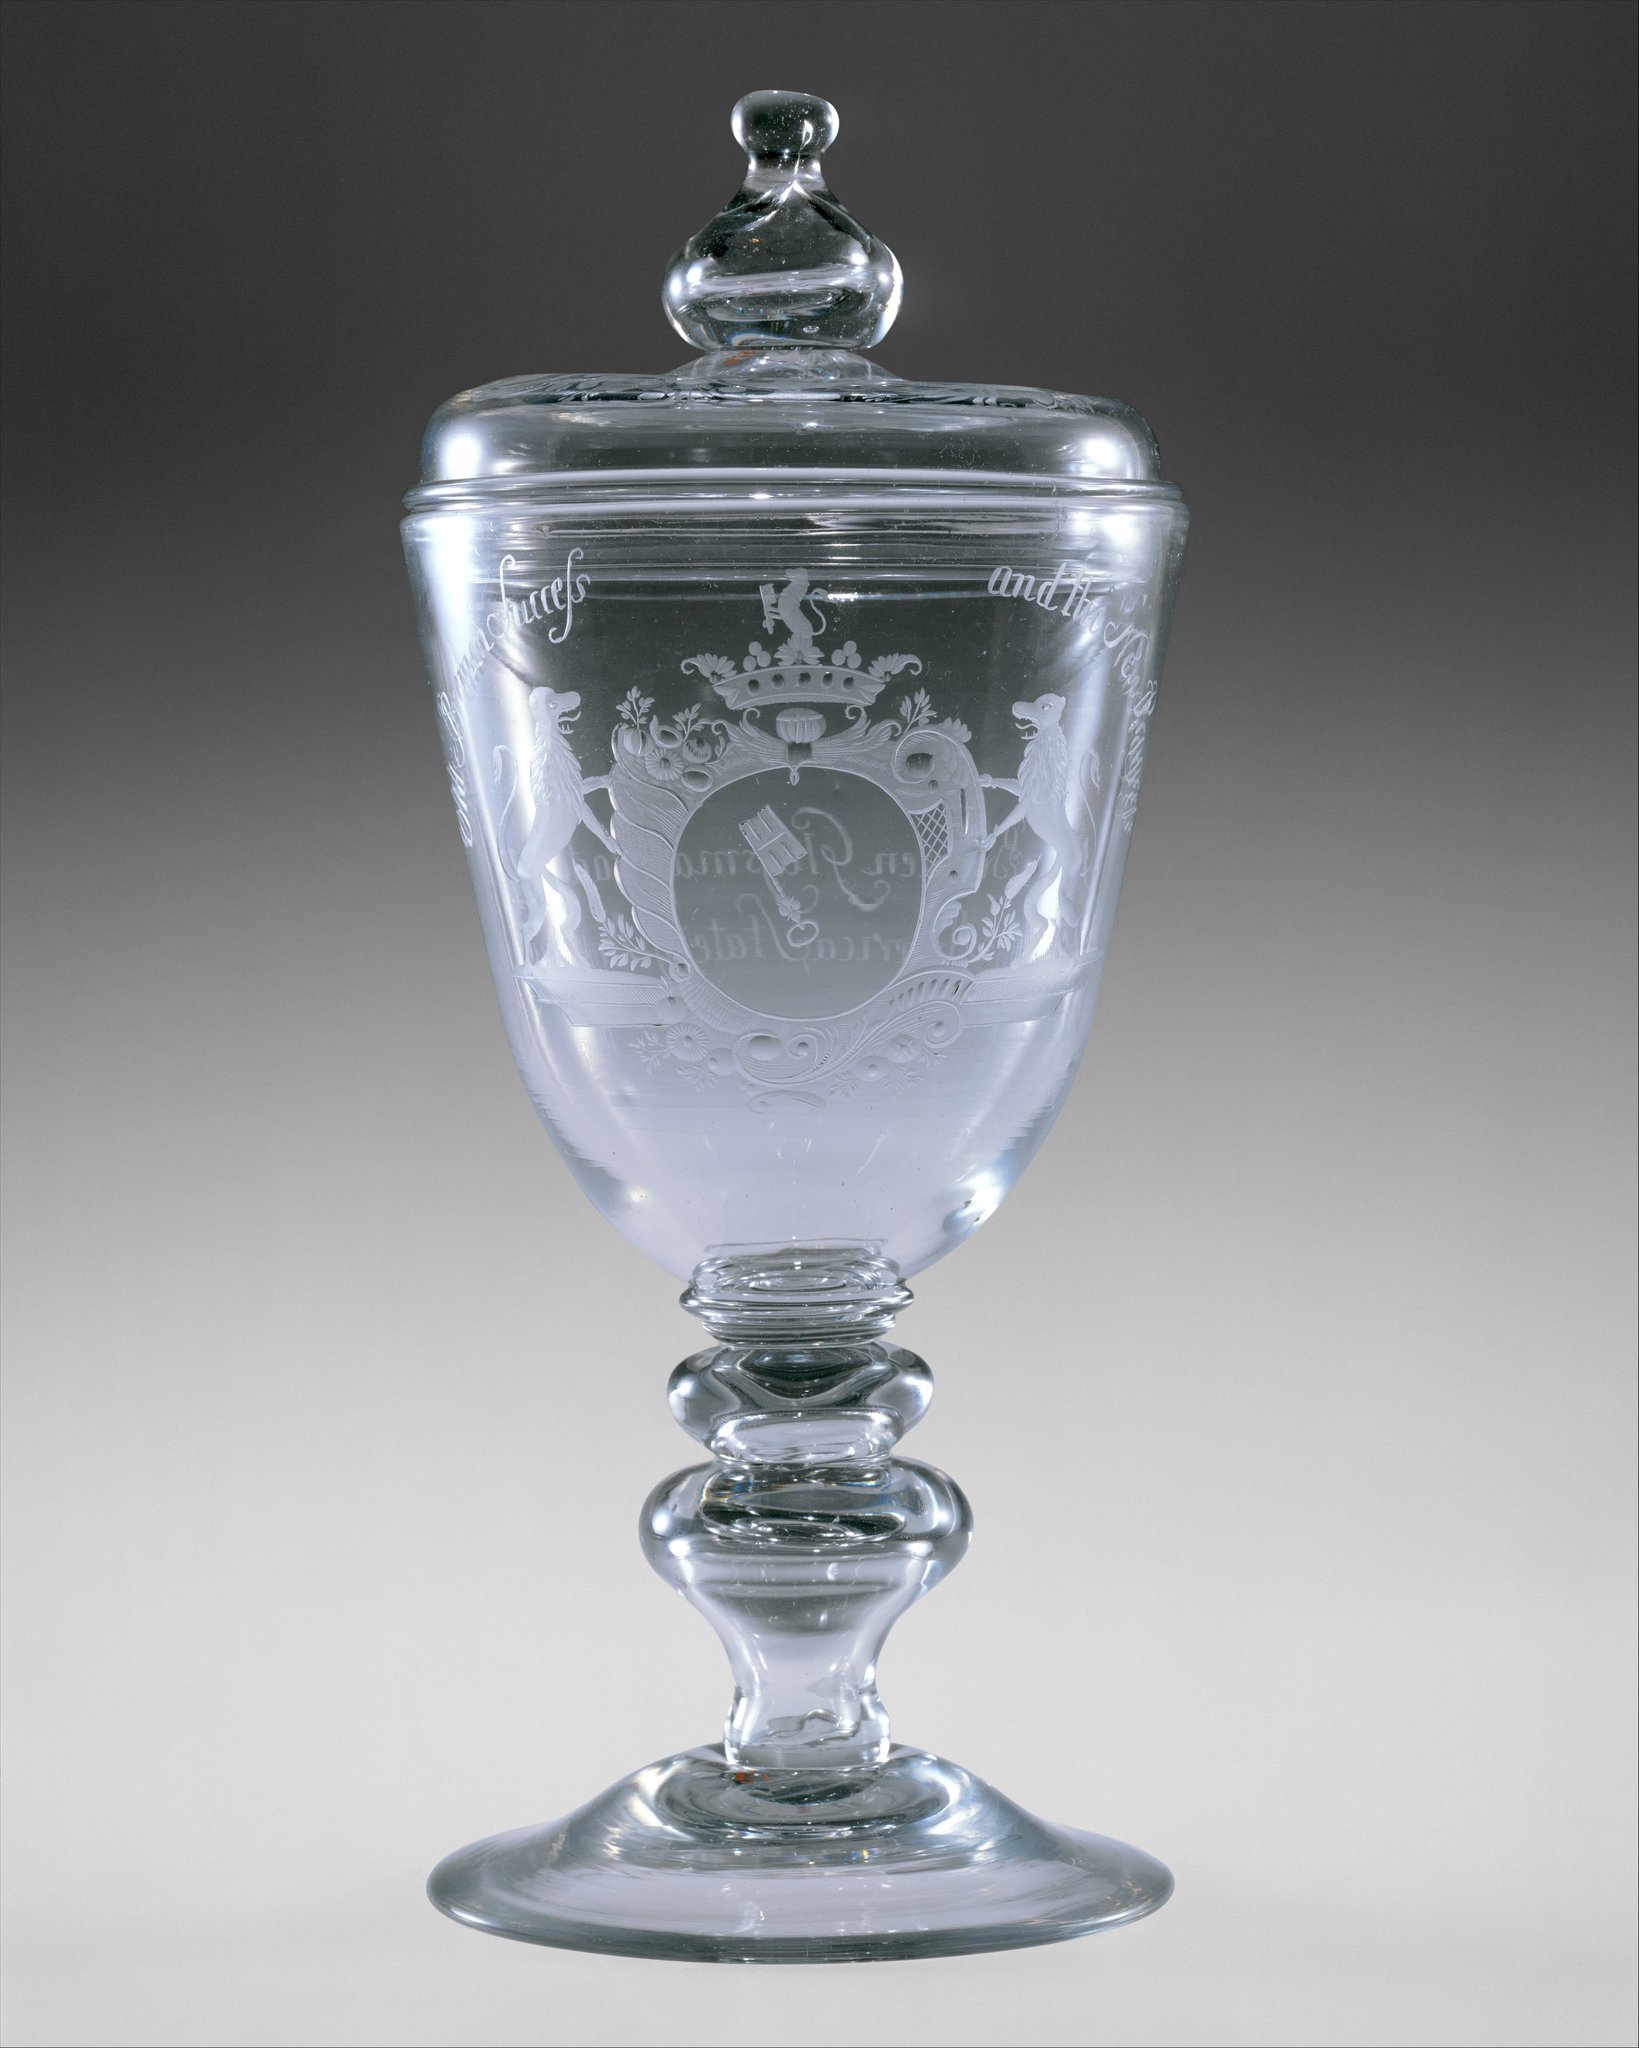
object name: goblet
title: Covered goblet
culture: american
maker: new bremen glass manufactory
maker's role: maker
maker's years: 1784-1795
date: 1788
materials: glass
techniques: glassblowing, engraving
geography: united states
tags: coat of arms